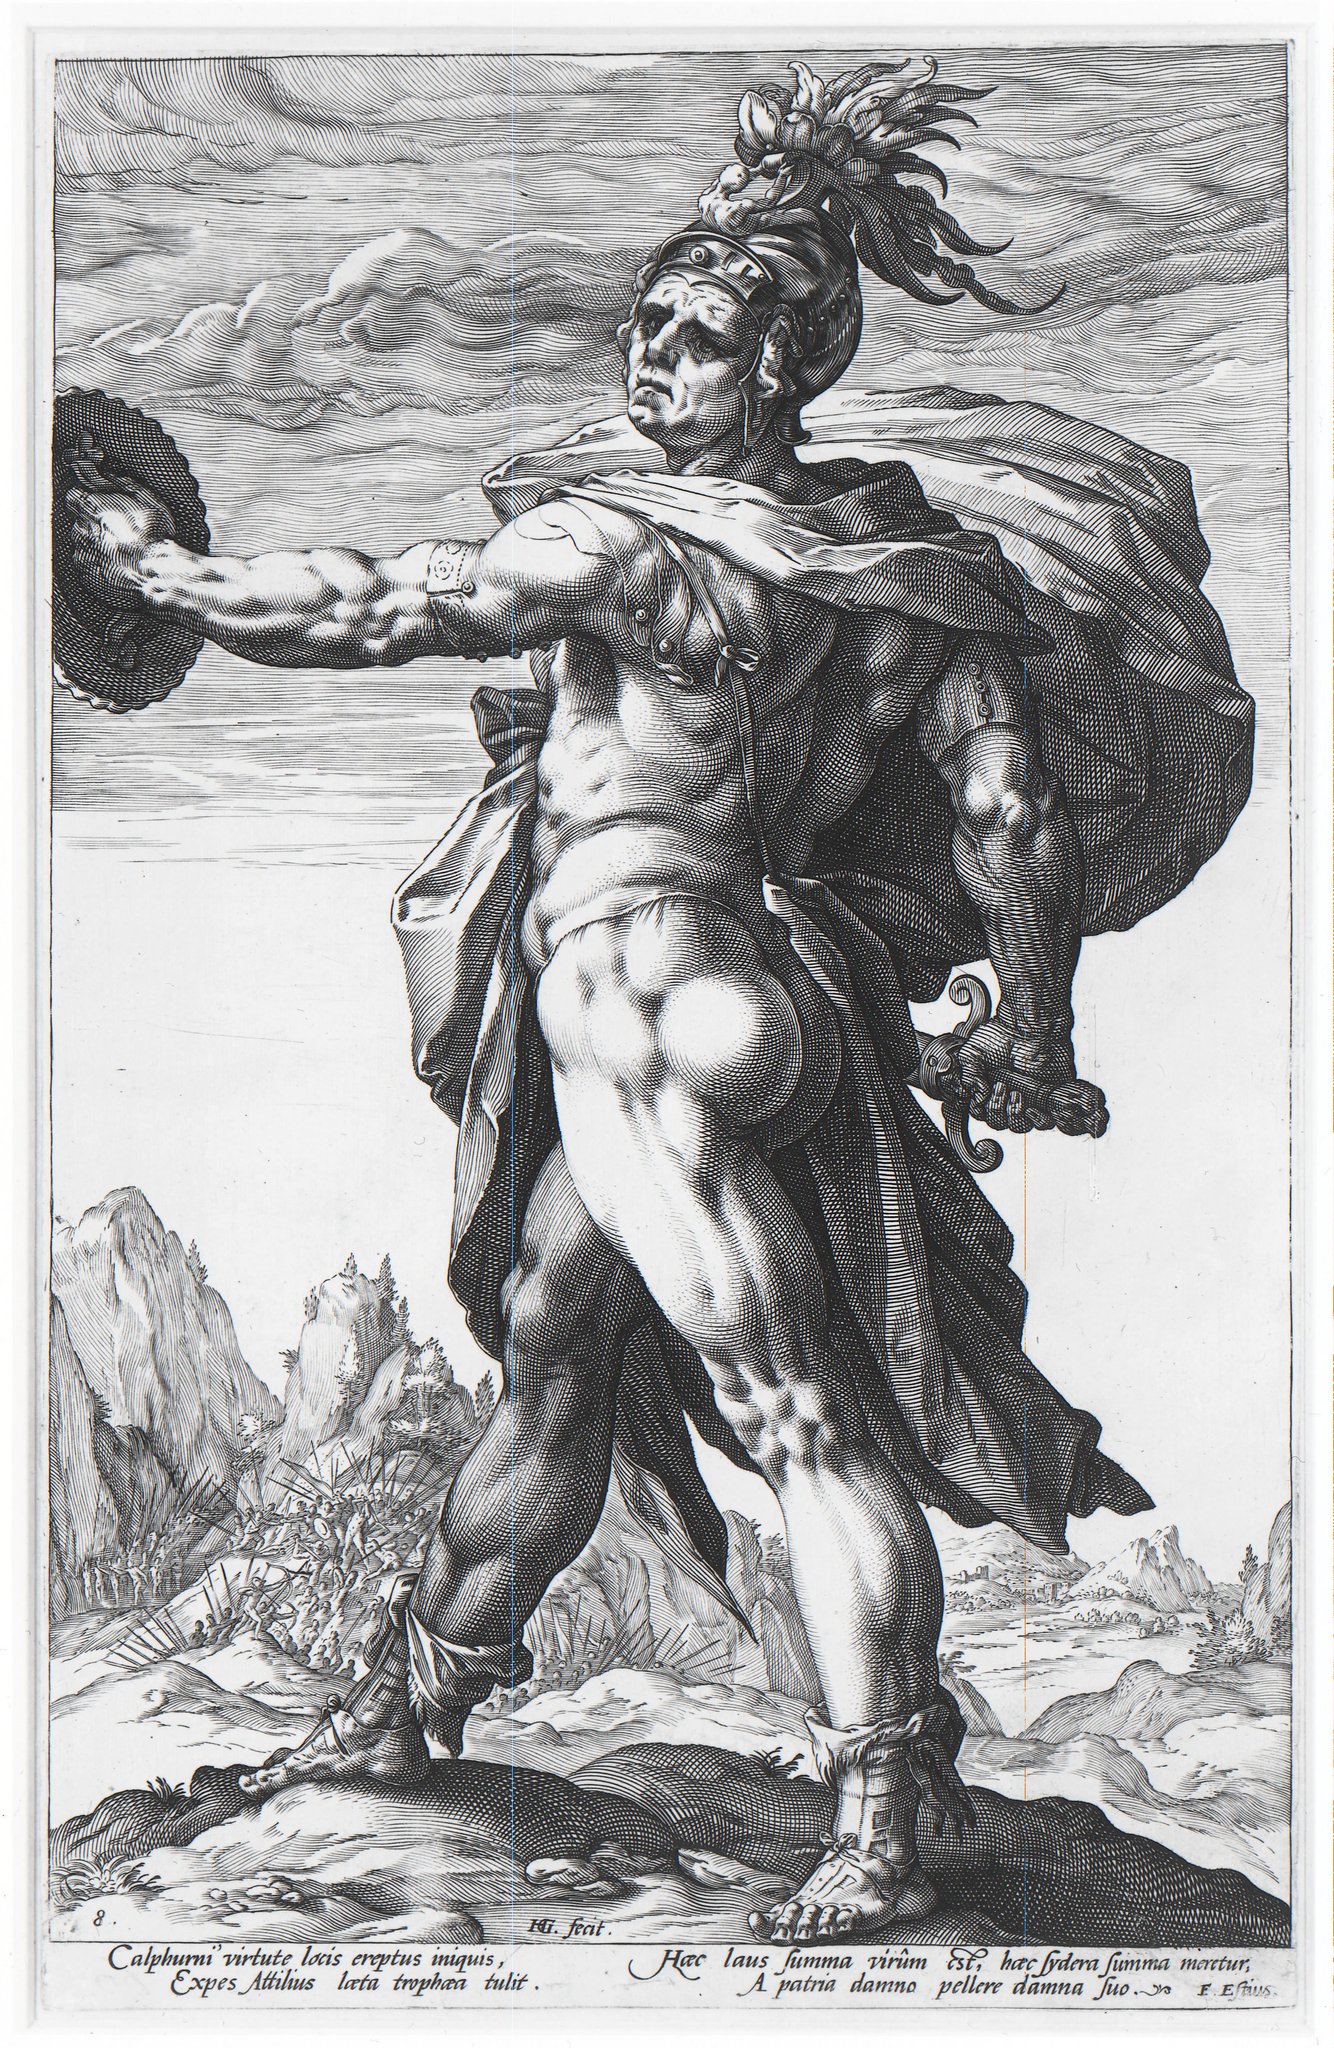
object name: print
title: De Romeinse helden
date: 1586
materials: paper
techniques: engraving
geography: haarlem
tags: male persons from classical history (calpurnius, m.)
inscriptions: collector's mark: Lugt 240, signature: ‘HG. fecit’, caption: ‘Calphurni virtute...damna suo.’, number: ‘8.’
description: De held Marcus Calpurnius Flama ten voeten uit, op de linkerzijde gezien. Op de achtergrond is te zien hoe hij met een klein leger consul Attilius Calatinus redde uit een hinderlaag. Onder de voorstelling twee maal twee versregels in Latijn. Deze prent is onderdeel van een serie van tien prenten, bestaand uit een ongenummerde titelprent, acht genummerde voorstellingen van helden en een ongenummerde afsluitende prent.